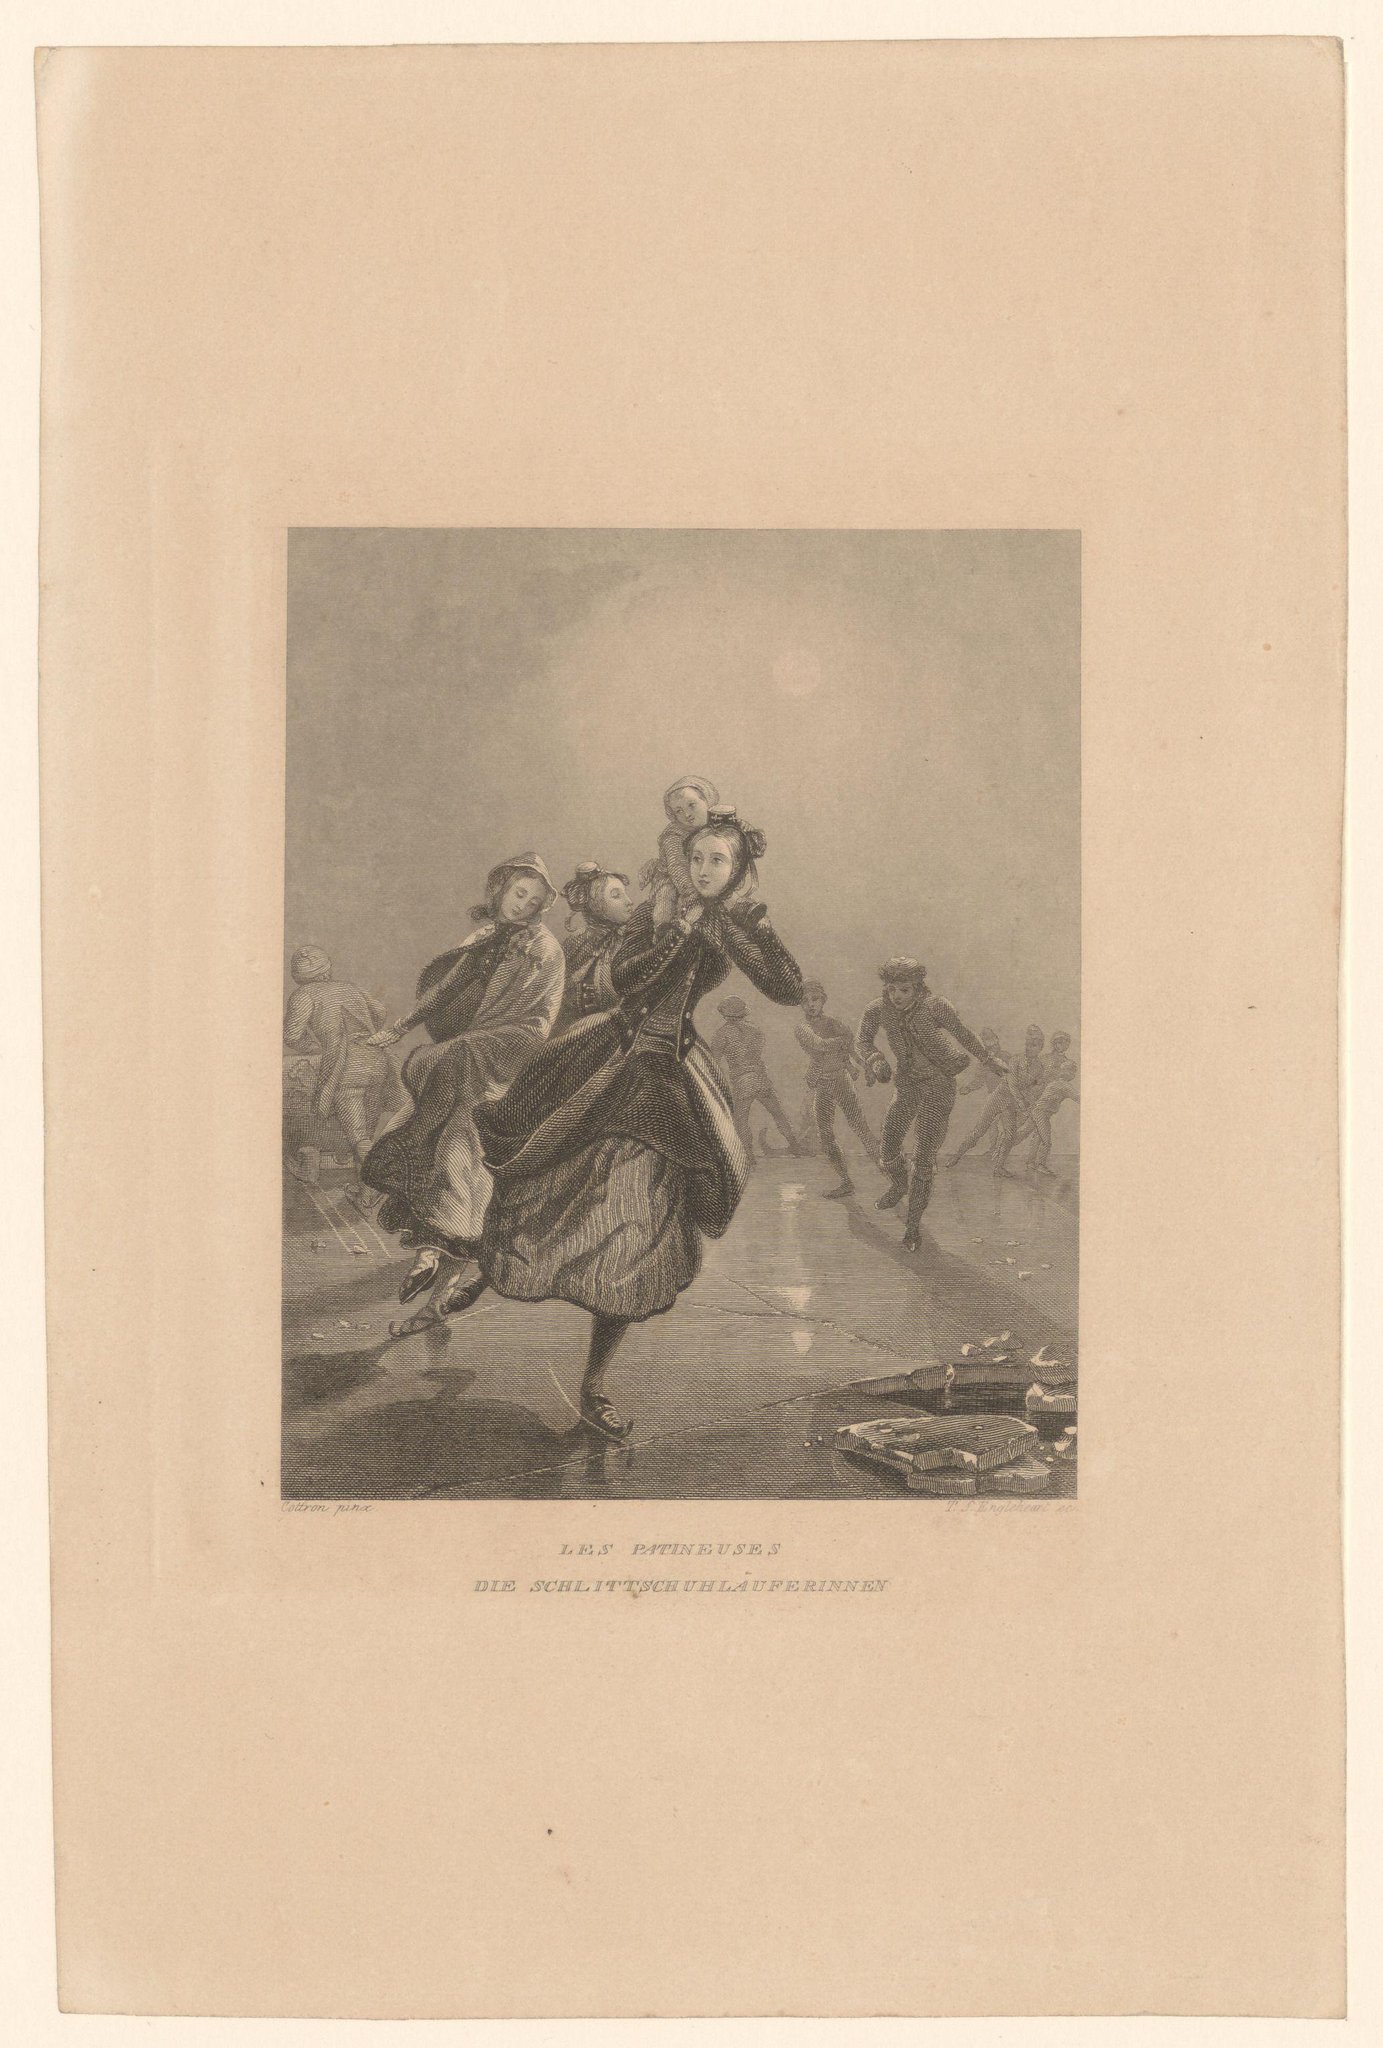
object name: print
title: Les Patineuses / Die Schlittschuhlauferinnen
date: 1813-1879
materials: paper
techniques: etching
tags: skates (winter sports)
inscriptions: collector's mark: Lugt 2228